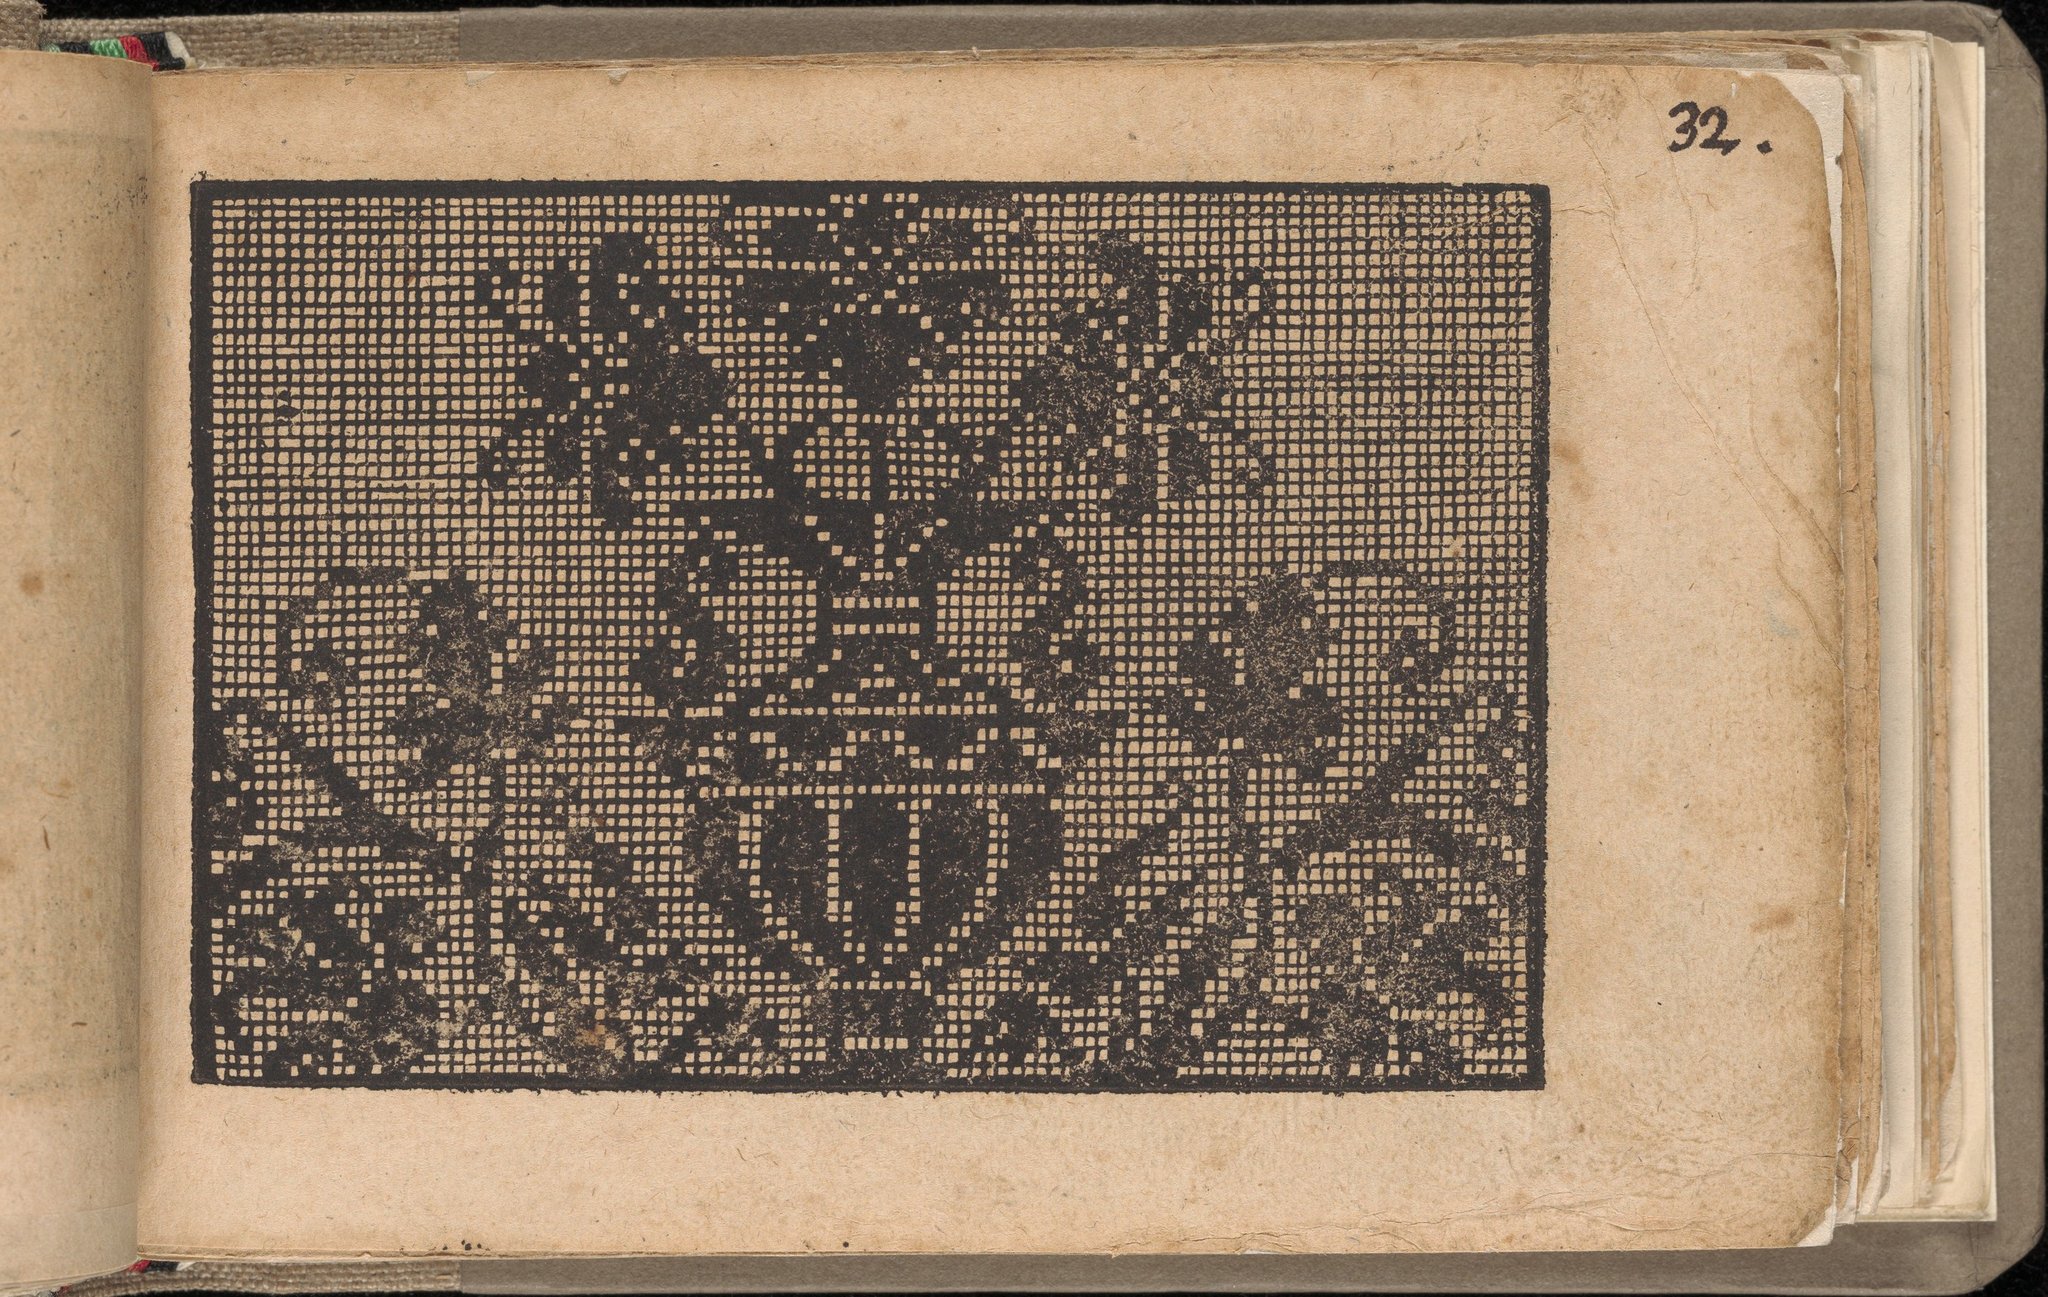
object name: book print ornament architecture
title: Schön newes Modelbuch (Page 32r)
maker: sigismundus latomus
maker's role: publisher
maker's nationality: german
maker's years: 1599-1632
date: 1608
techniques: woodcut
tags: ornament,flowers,vases